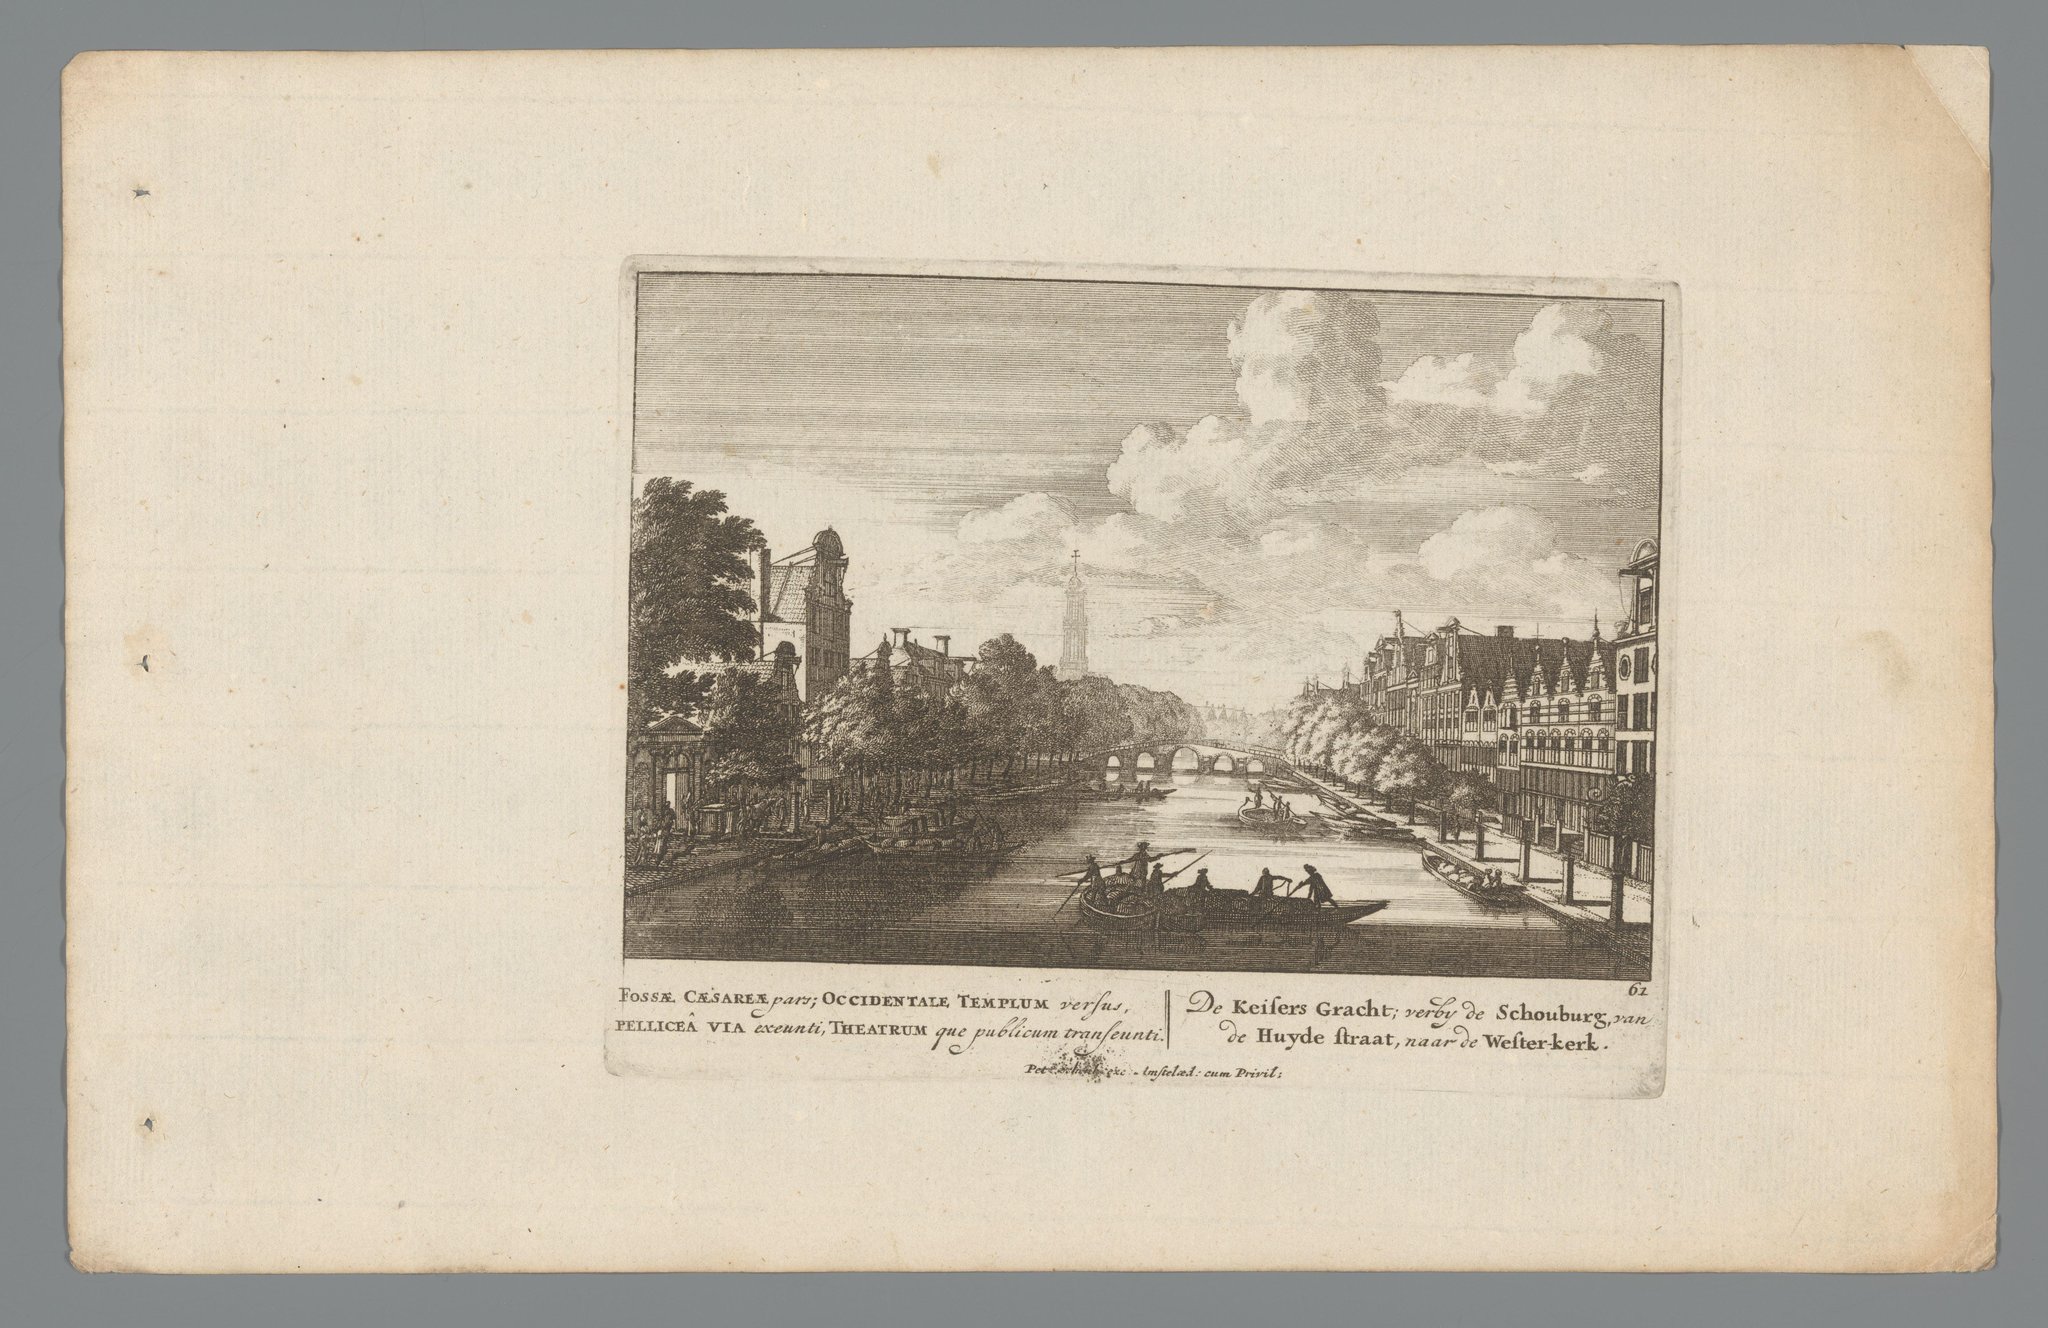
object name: print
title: Viervoudig schouwspel van wonderen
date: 1700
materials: paper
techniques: engraving, etching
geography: amsterdam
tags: bridge in city across river, canal, etc., canals, waters (in city) (+ city(-scape) with figures, staffage), street (+ city(-scape) with figures, staffage), parts of church exterior and annexes: tower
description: Andere staat ook gebruikt in: Call, Jan van. Admirandorum Quadruplex Spectaculum. Amsterdam: Pieter Schenk (I), 1700. De titelprent, opdracht en het portret van Frederik van Saksen zijn gegraveerd door Pieter Schenk (I). De overige prenten uit deze serie zijn, zoals aangegeven op de titelprent, van de hand van Jan van Call (I).